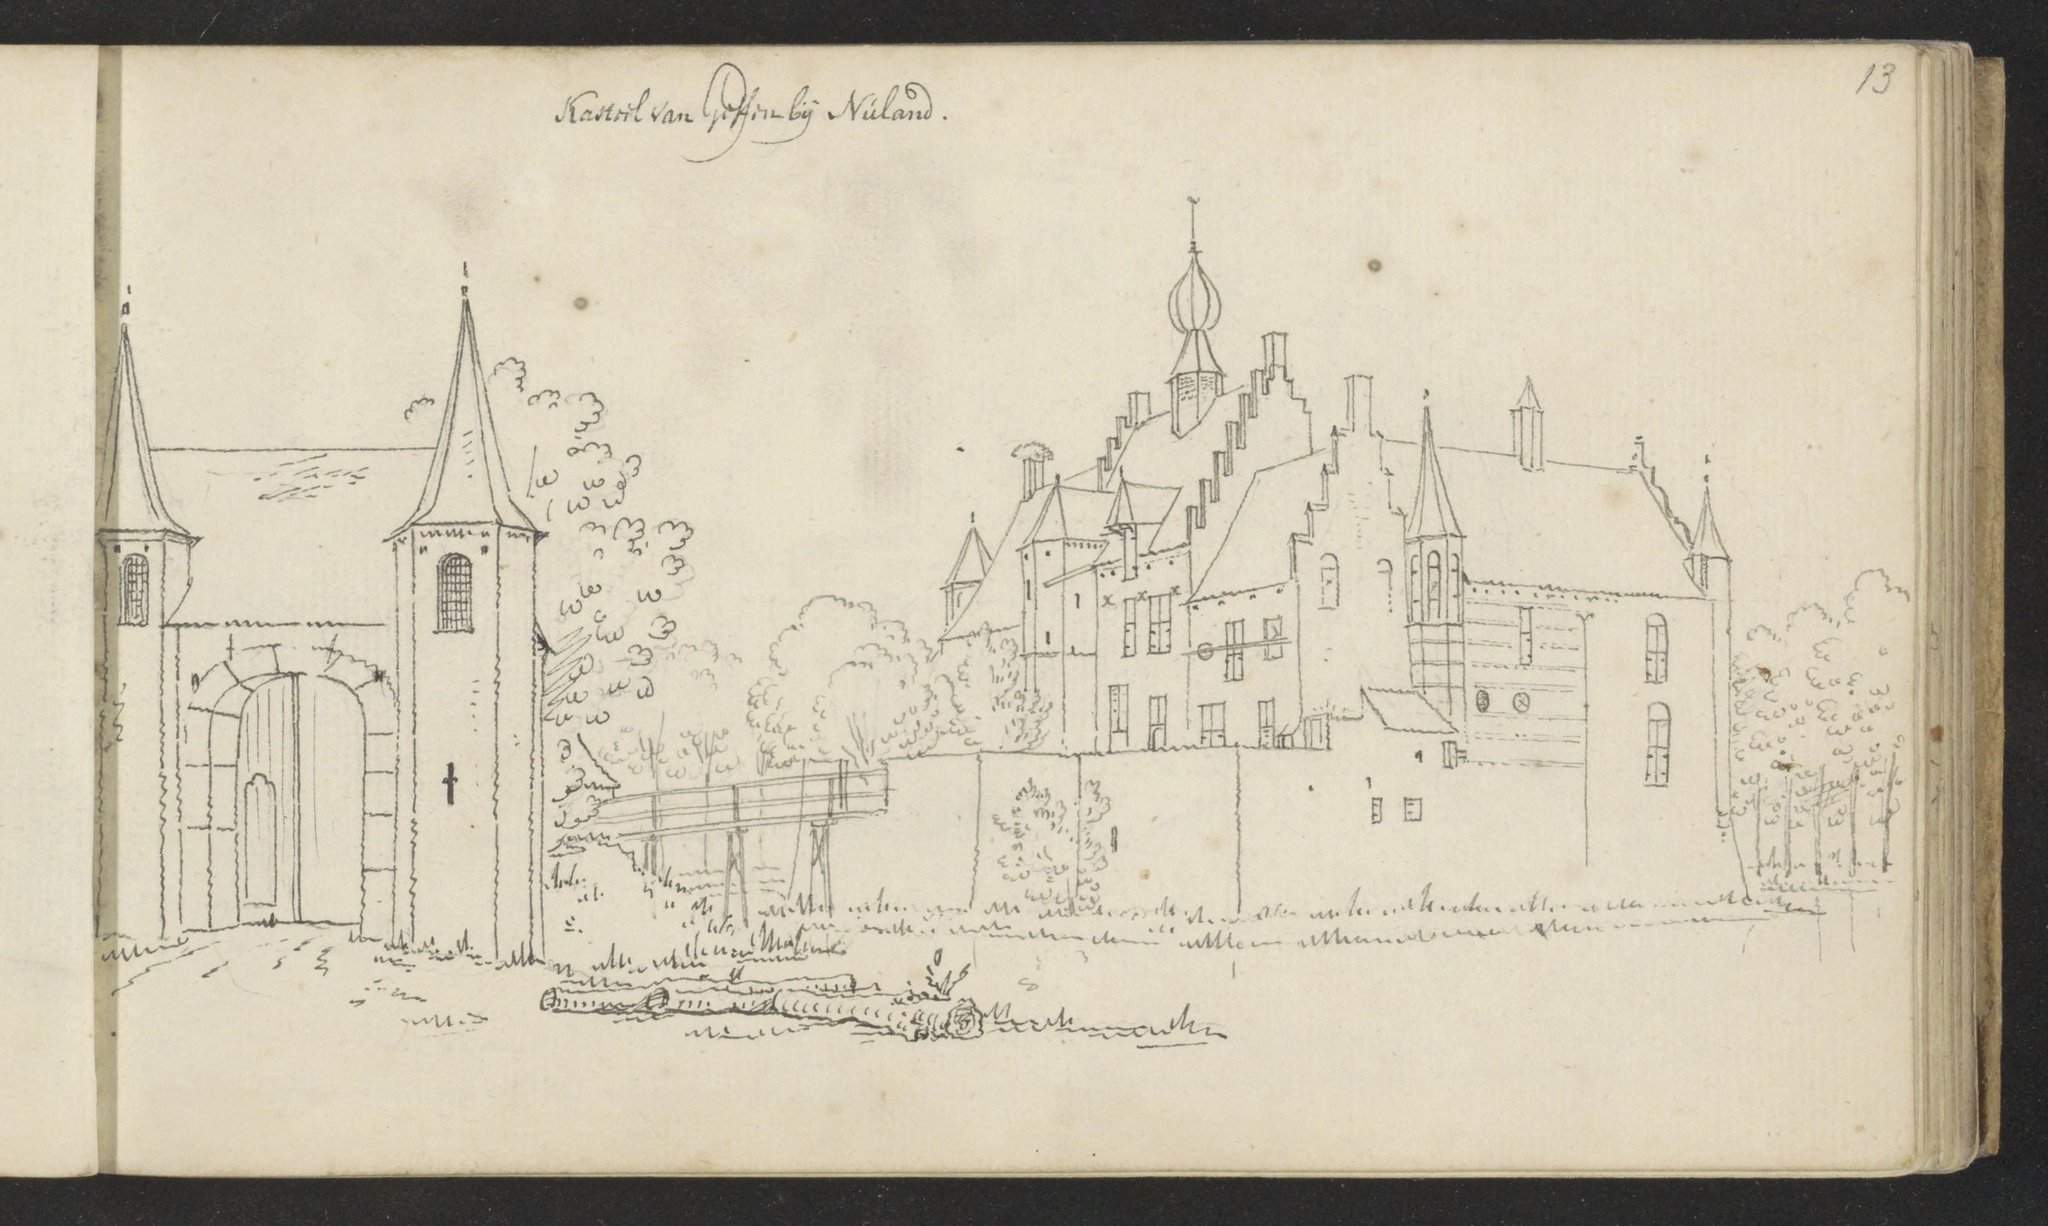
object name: sketchbook leaf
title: Kasteel van Geffen bij Nuland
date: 1701-1759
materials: ink, paper, pencil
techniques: pen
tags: castle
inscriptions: annotation: ‘Kasteel van Geffen bij Nuland’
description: Blad 13 recto uit een schetsboek met 65 bladen.